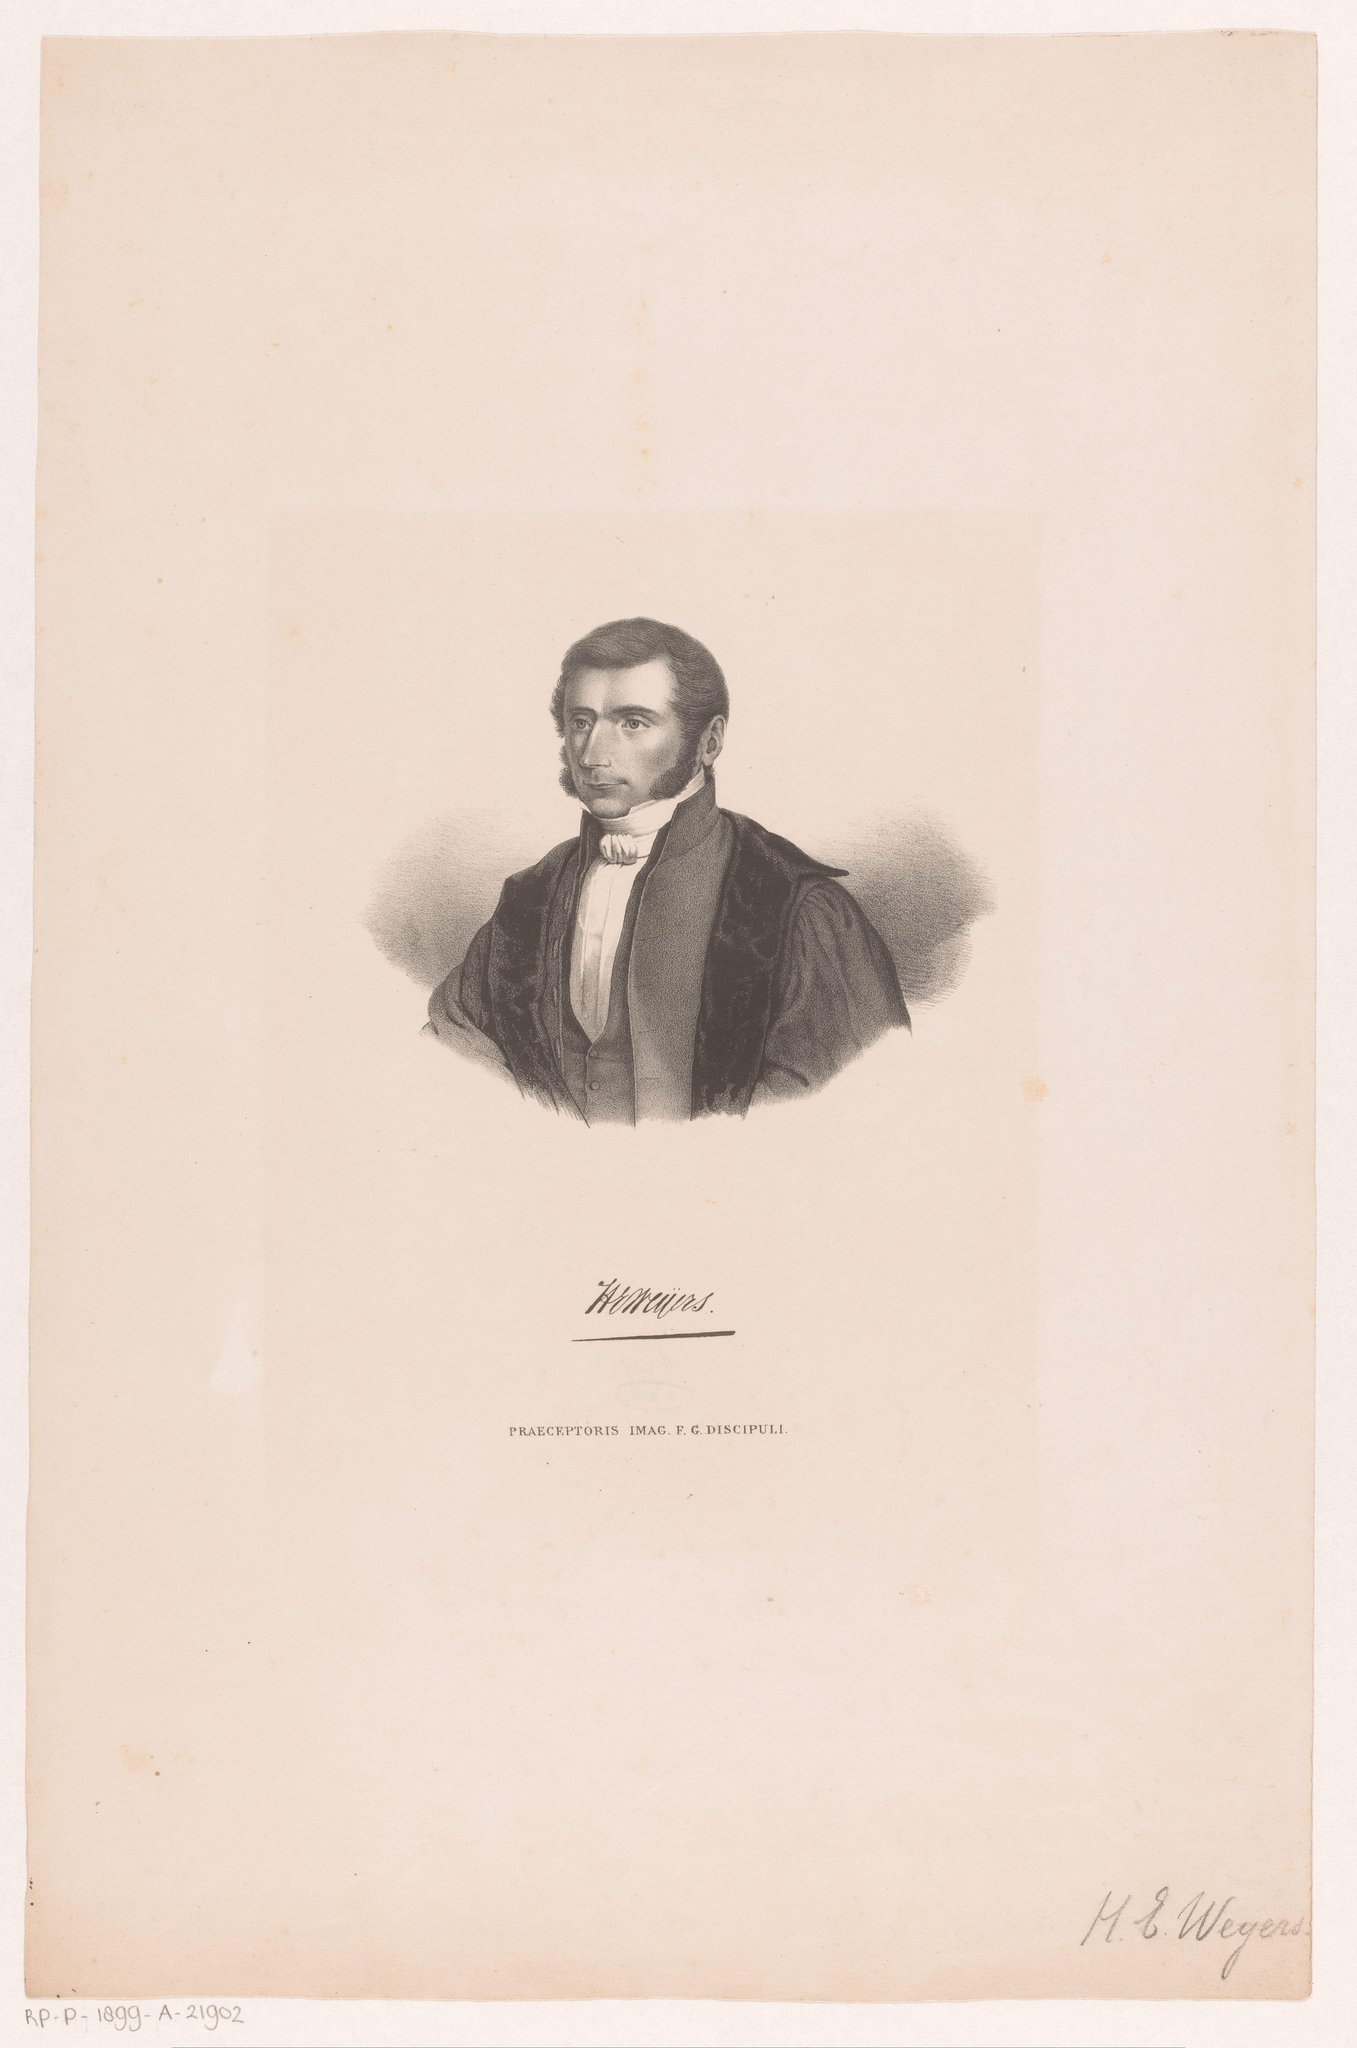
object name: print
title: Portret van Hendrik Engelinus Weyers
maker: leendert springer (i)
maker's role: draughtsman, painter, print maker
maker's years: 1789-1871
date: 1809-1844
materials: paper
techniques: lithograph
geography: leiden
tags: historical persons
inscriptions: collector's mark: Lugt 2228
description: Onder het portret de signatuur van de geportretteerde.